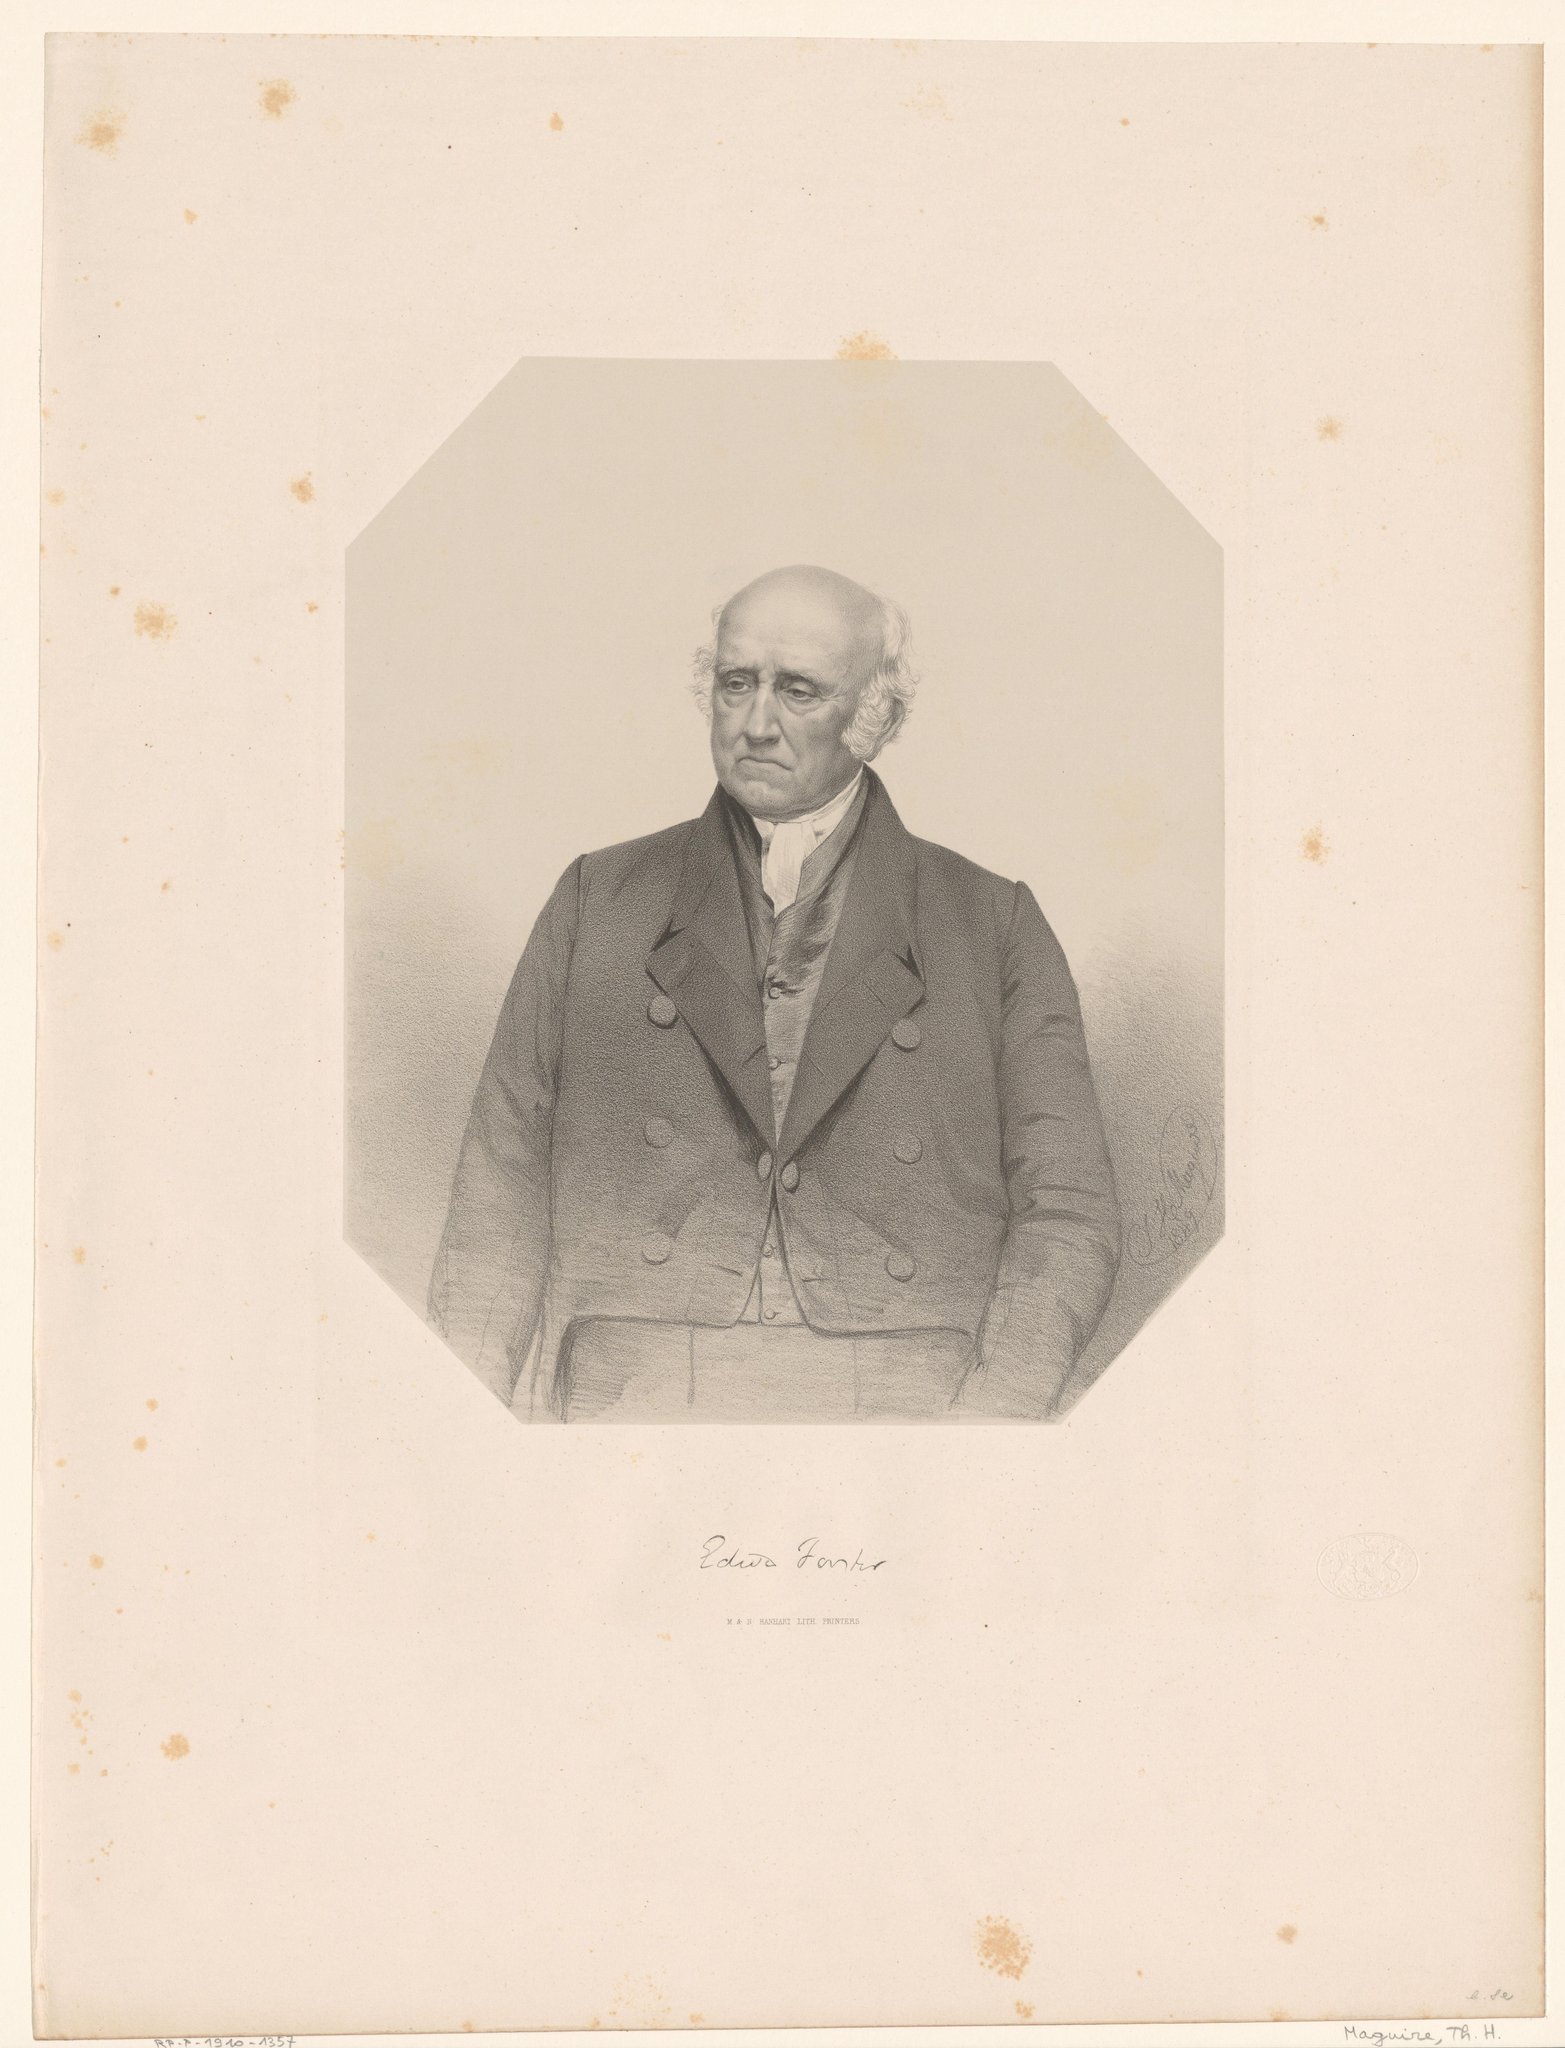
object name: print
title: Portretten uit het Ipswich Museum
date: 1852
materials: paper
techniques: lithograph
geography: london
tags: adult man, historical persons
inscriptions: collector's mark: Lugt 2228, check stamp: ‘Ipswich Museum’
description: Prent behoort tot de serie 'Ipswich Museum Portraits', ook bekend onder de titel 'Portraits of Honorary Members of the Ipswich Museum'. Deze serie is in 1852 door George Ransome uitgegeven en gedrukt door M&N Hanhart tussen 1848 en 1852. De serie bestaat uit ca. 60 portretten.